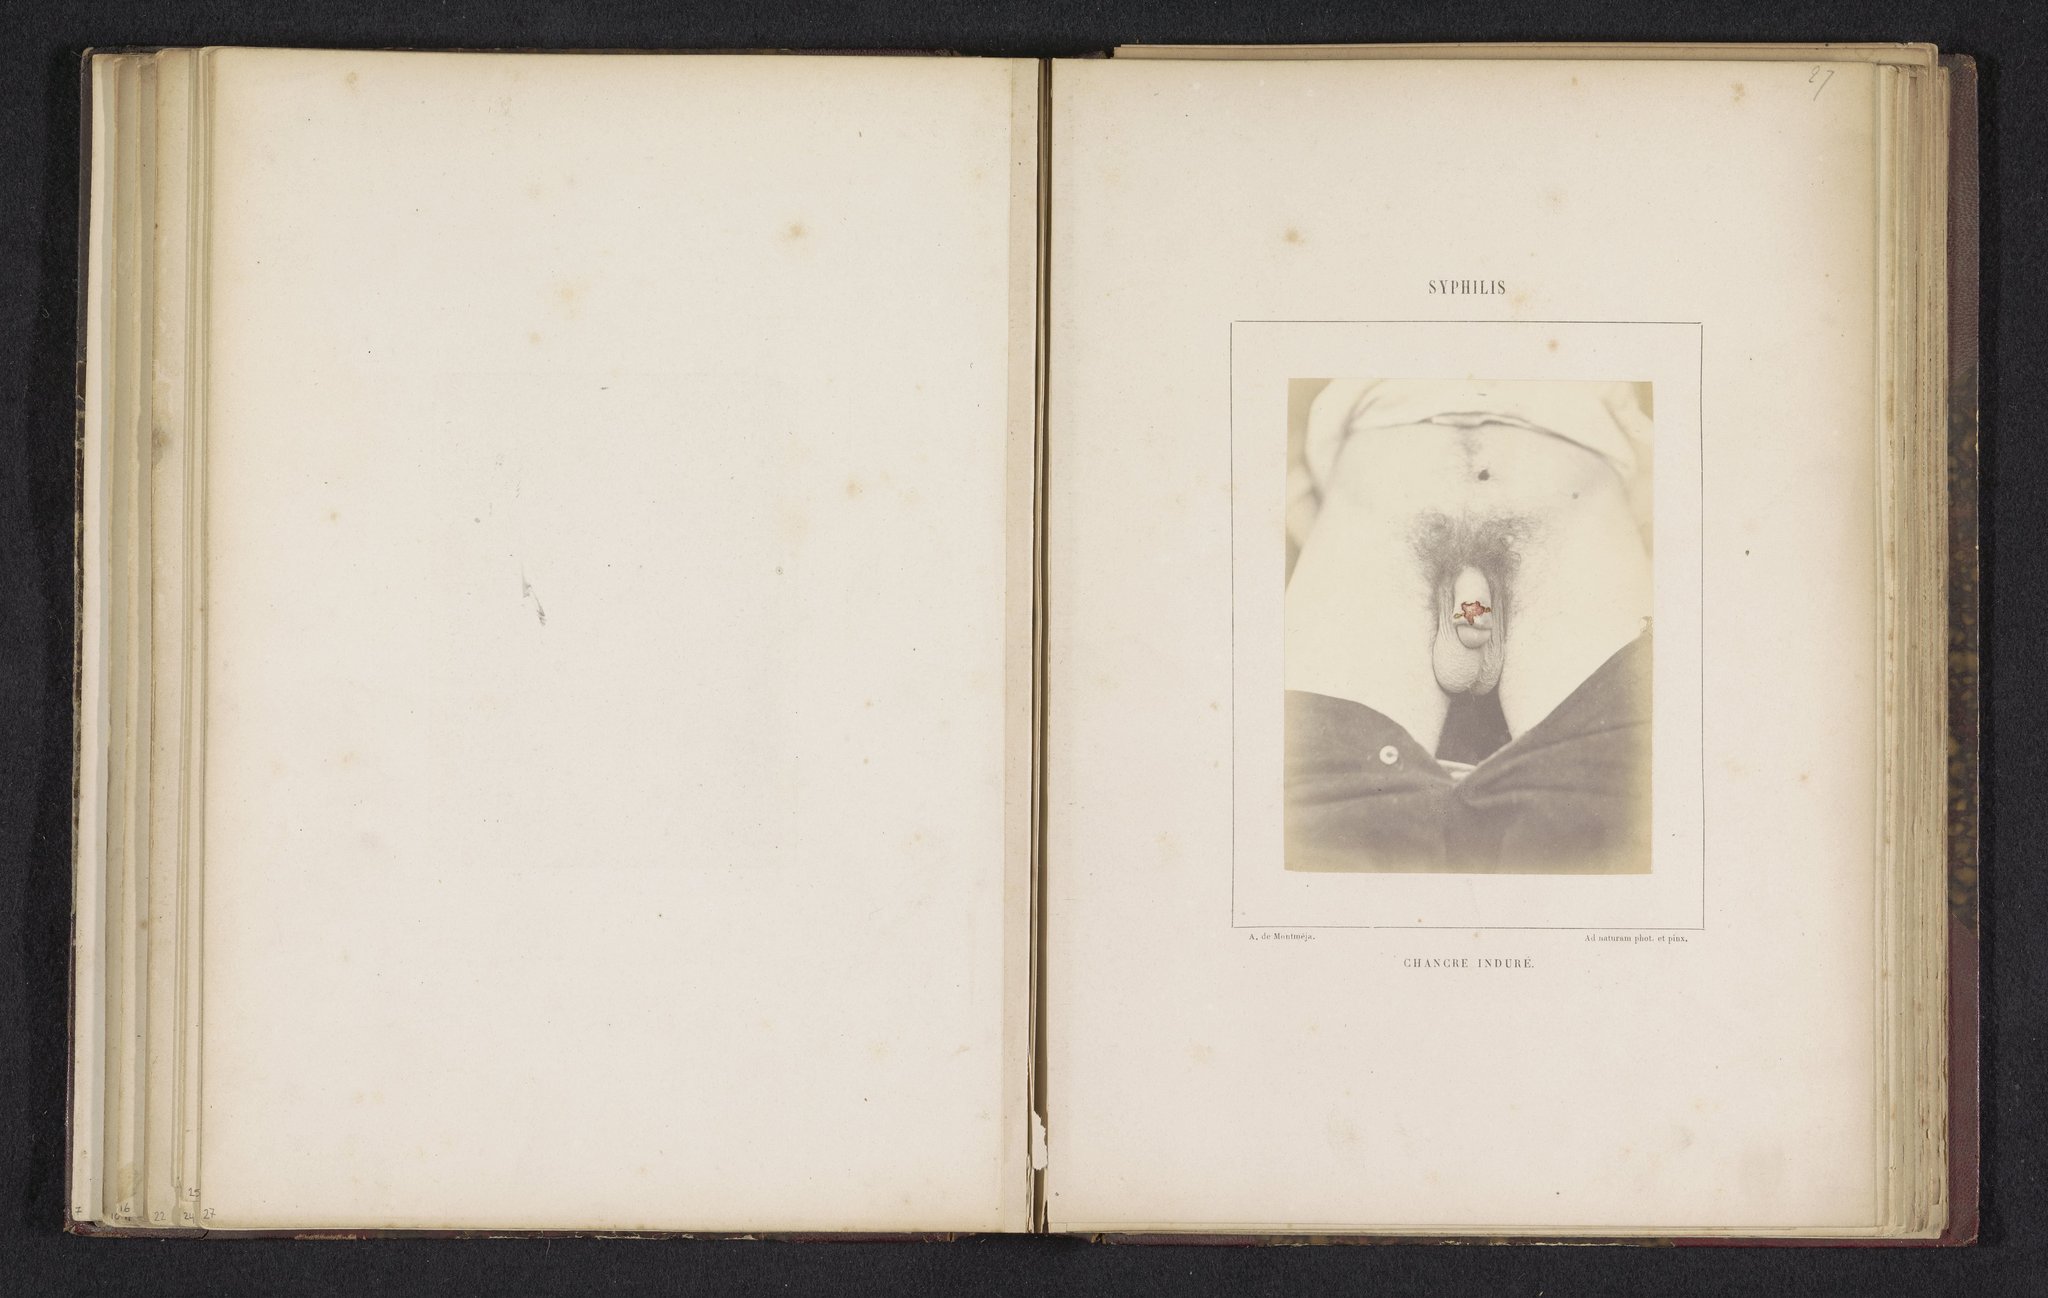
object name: photograph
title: Chancre induré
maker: a. de montméja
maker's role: arts, fotograaf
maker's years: 1841-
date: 1860-1868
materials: photographic support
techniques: albumen print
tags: skin and venereal diseases: syphilis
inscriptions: inscription: ‘Ad naturam phot. et pinx.’, number: ‘27’, inscription: ‘Syphilis’